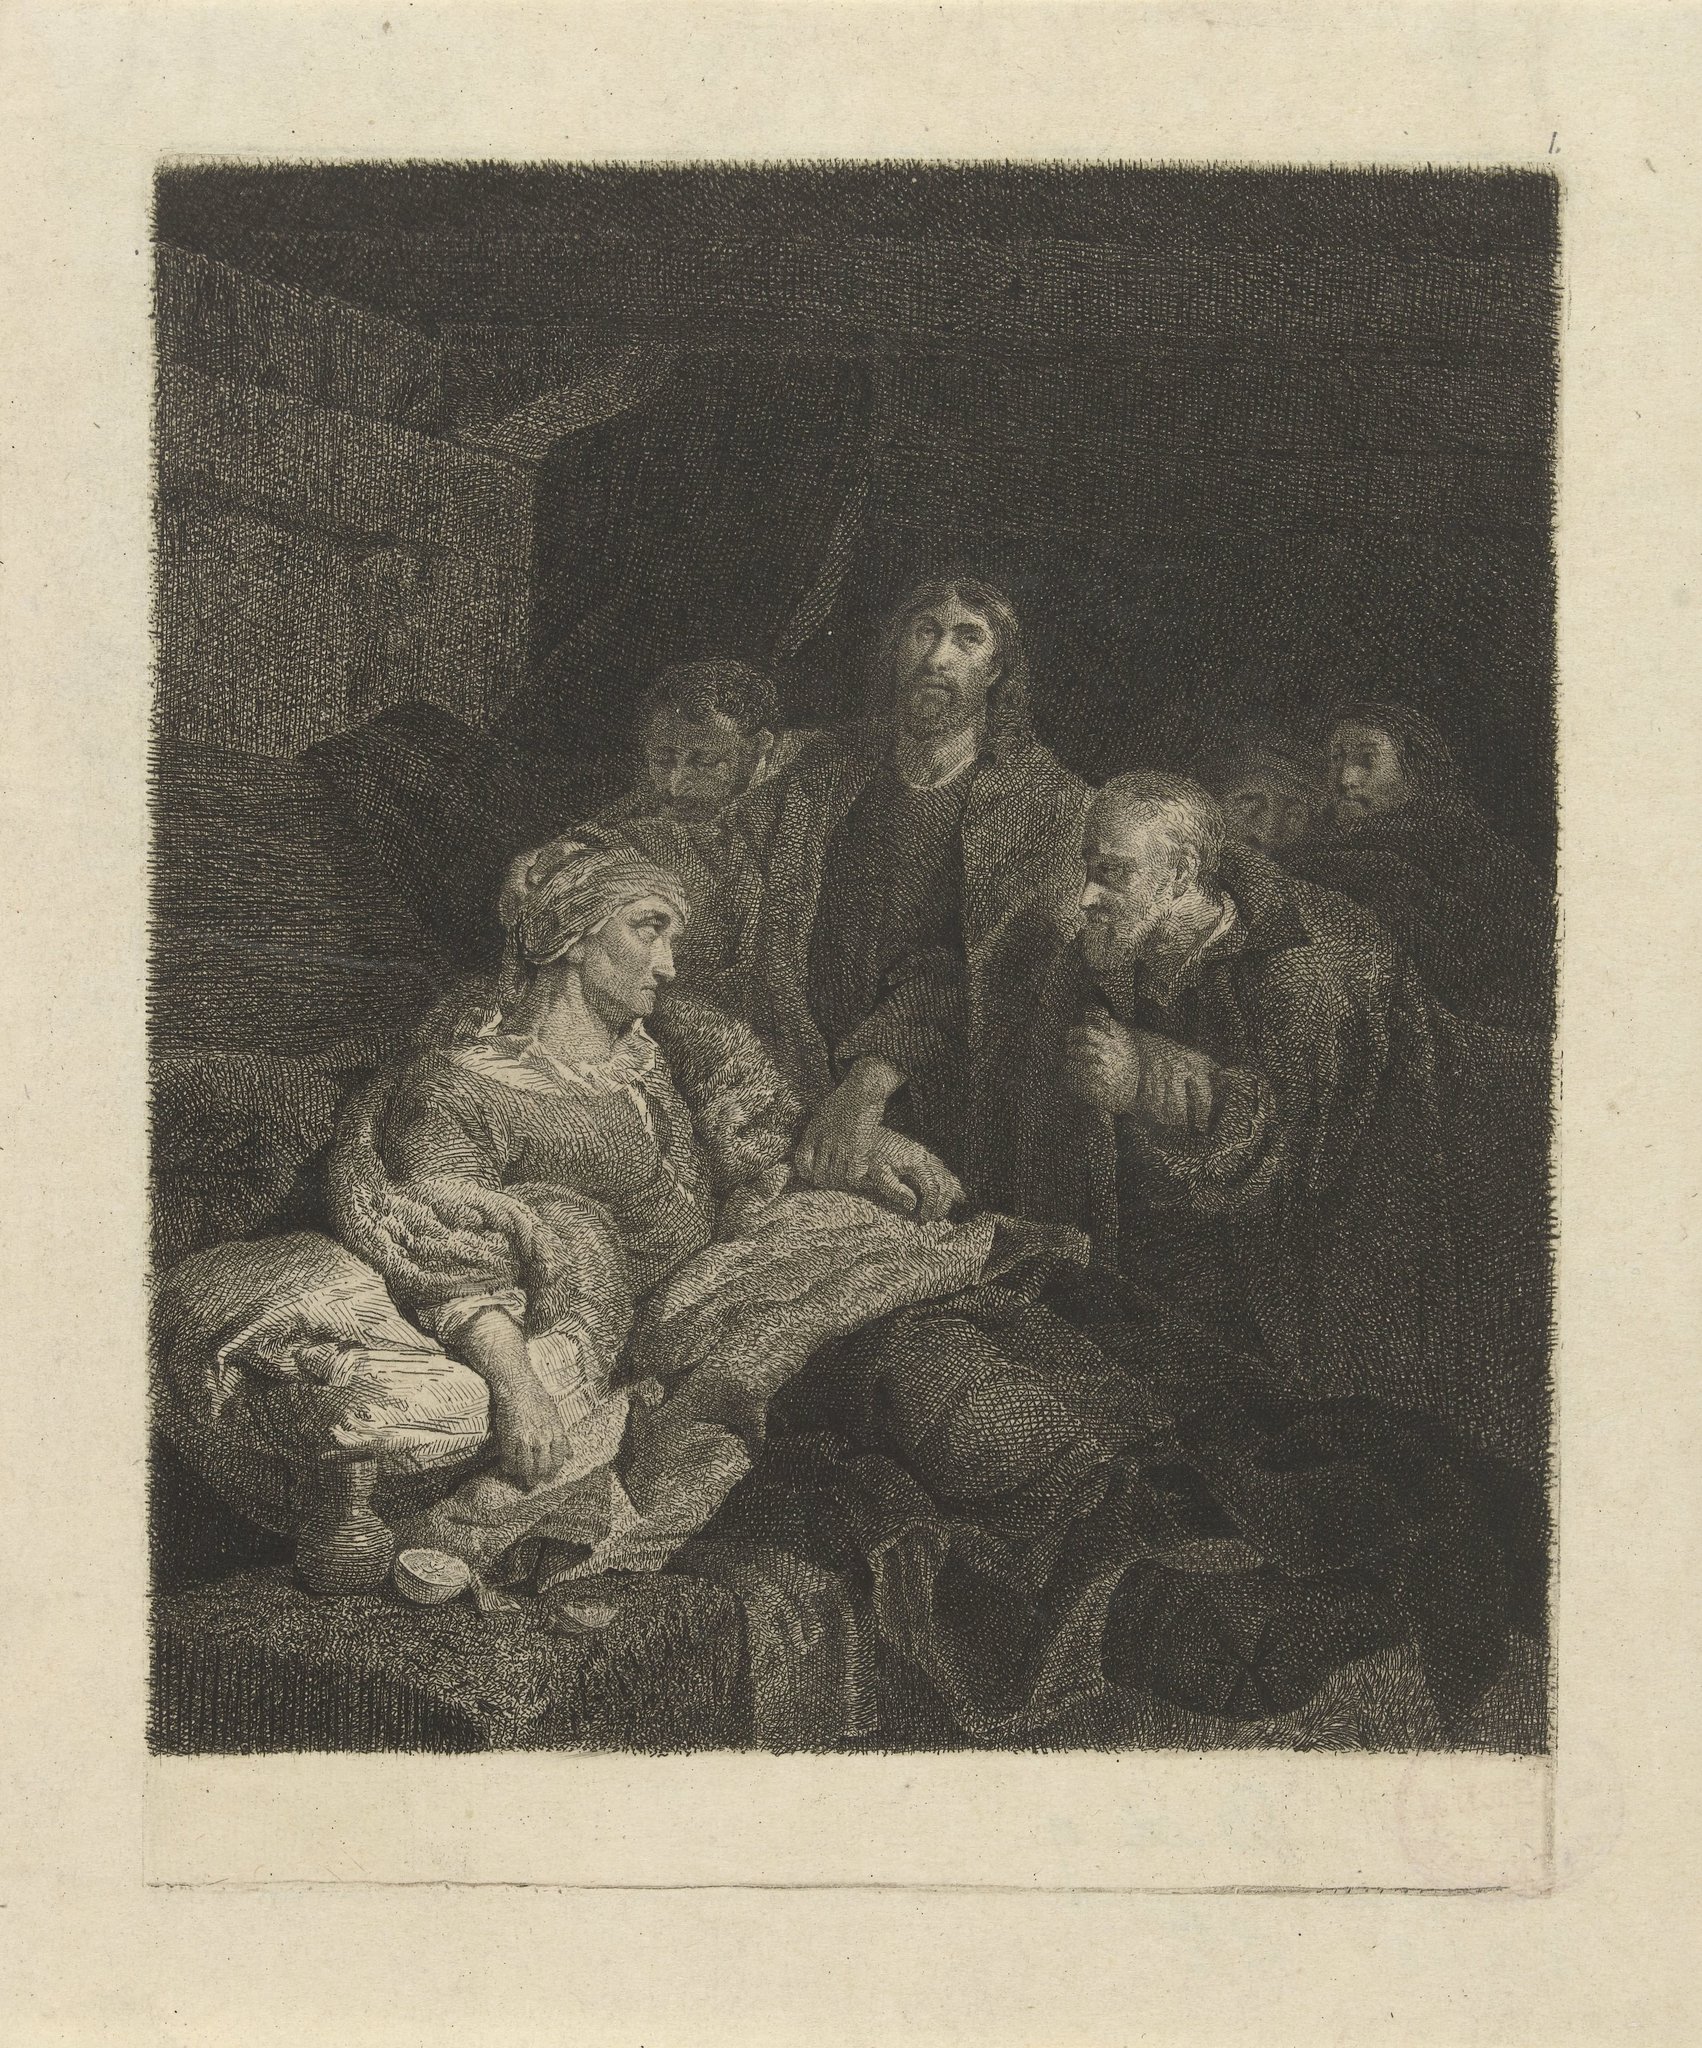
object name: print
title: Christus geneest de schoonmoeder van Petrus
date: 1797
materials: paper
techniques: etching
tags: healing of peter's mother-in-law (matthew 8:14-15; mark 1:29-31; luke 4:38-39)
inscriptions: collector's mark: Lugt 12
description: Christus staat aan het bed van de zieke schoonmoeder van apostel Petrus. Hij zegent haar en laat hierbij zijn ene hand op haar hoofd rusten, de andere hand omklemt de pols van de zieke. Terstond is zij genezen. Rondom het bed staan vier andere apostelen die getuige zijn van de genezing.